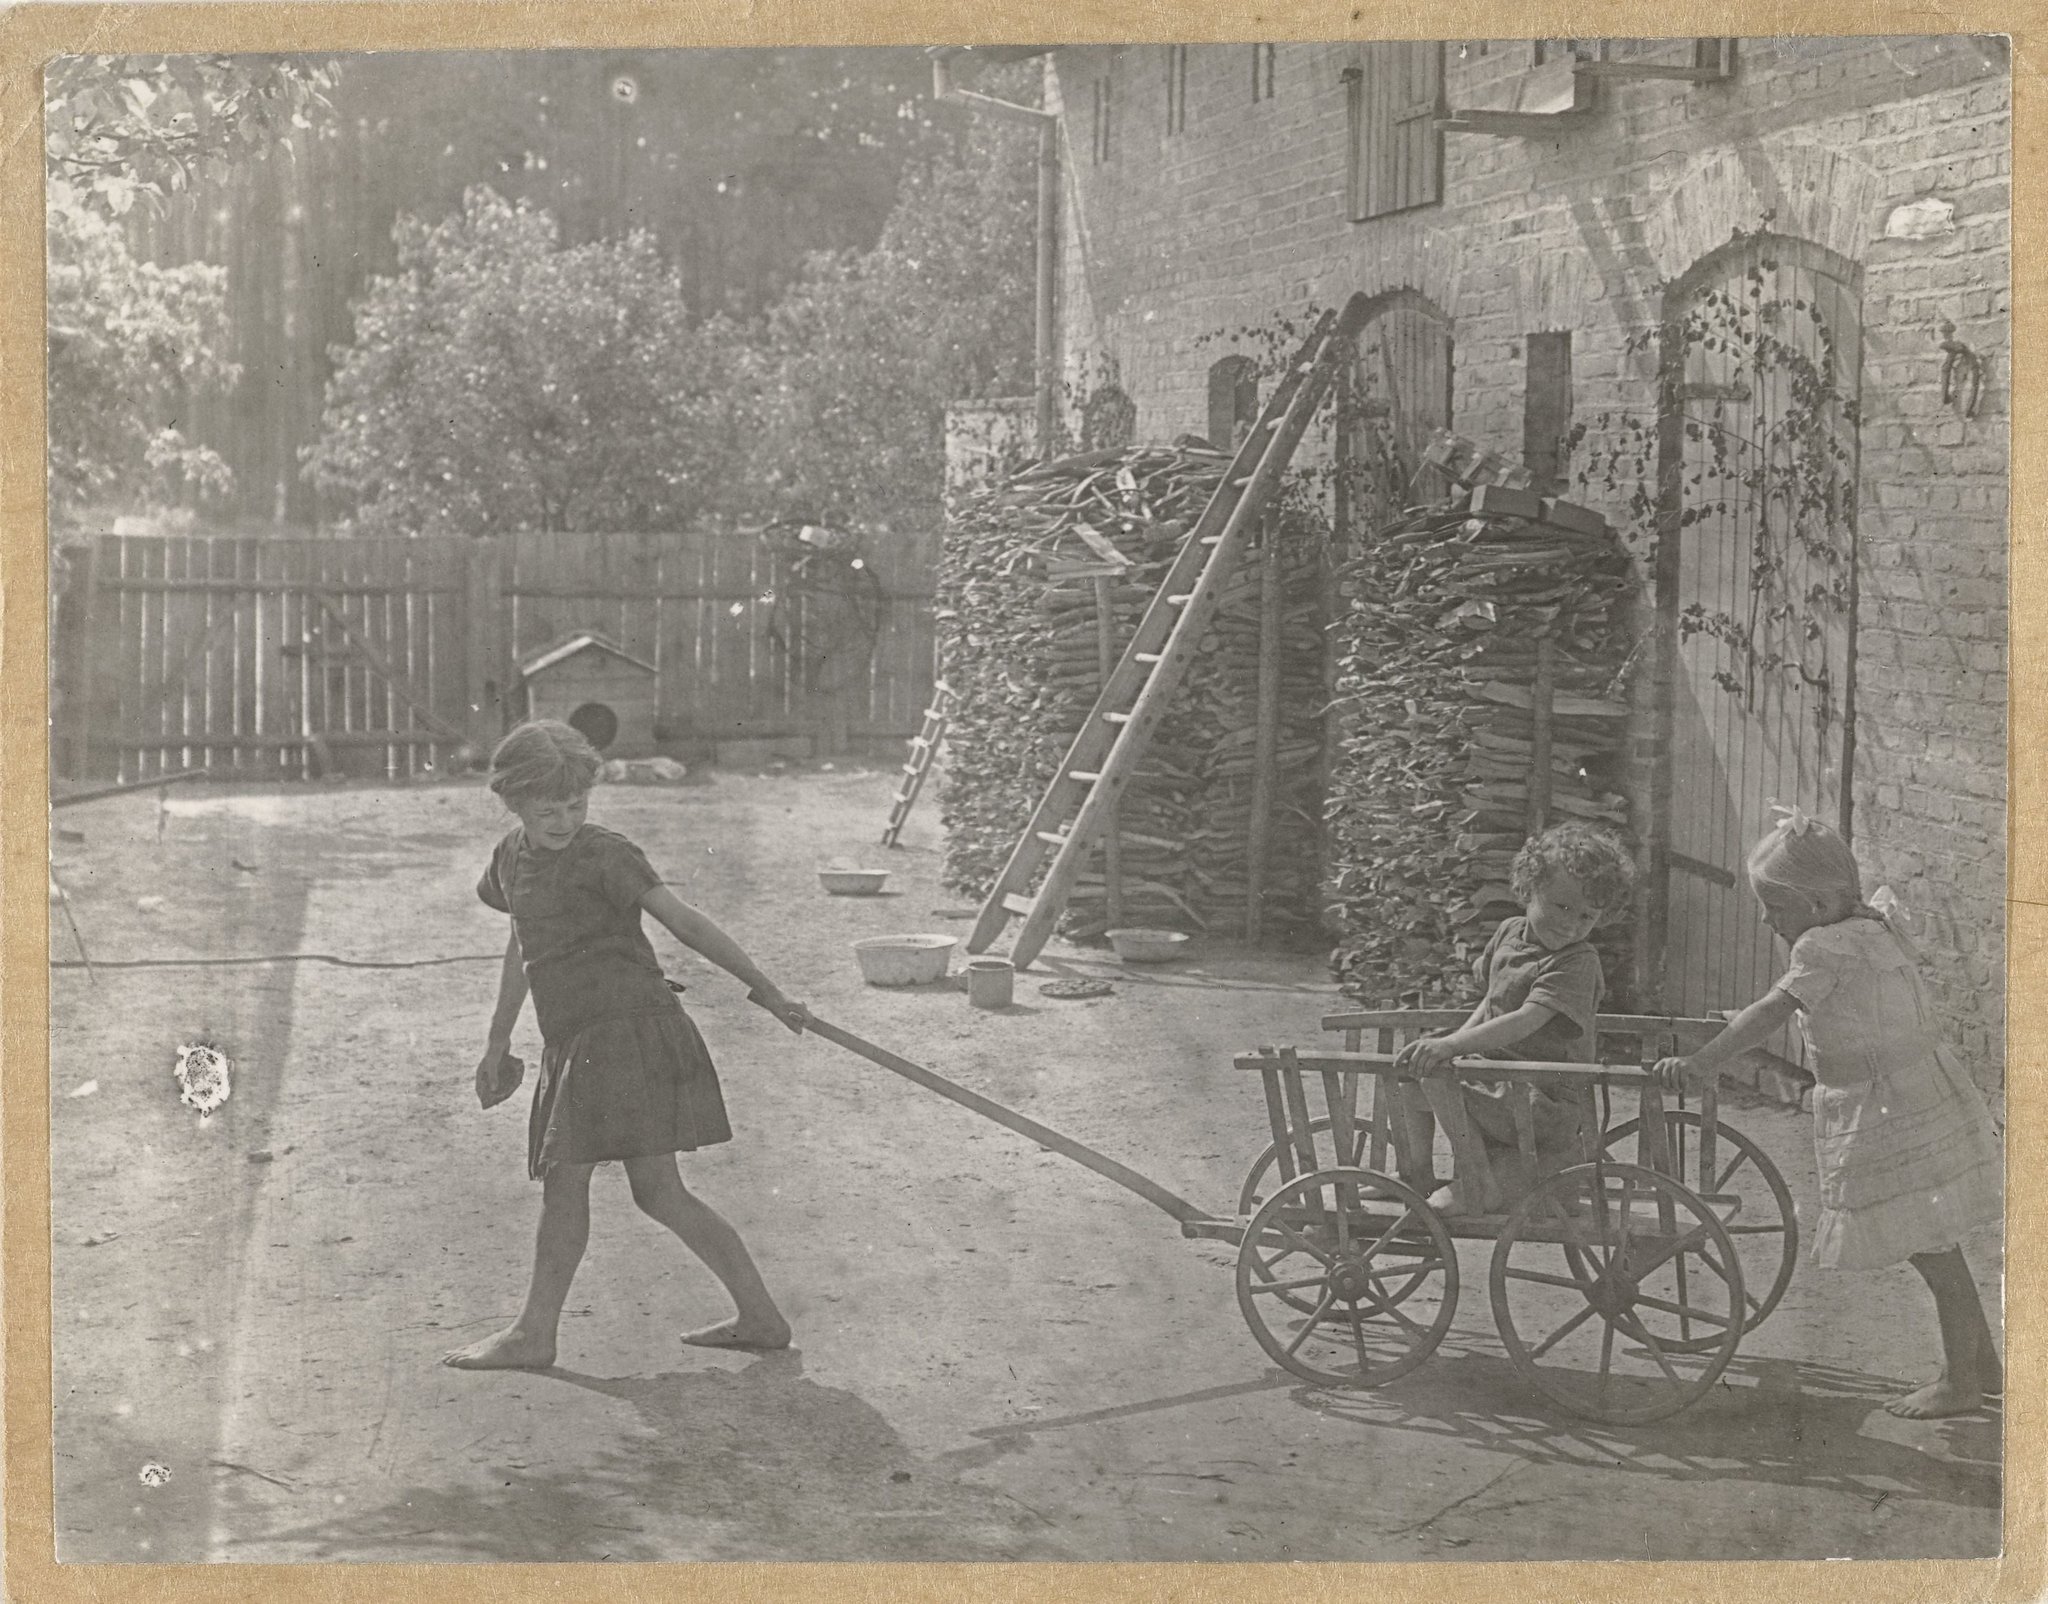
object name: photograph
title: Marba en Eckart Titzenthaler, kinderen van de fotograaf, en een onbekend meisje spelend met een kar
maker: waldemar titzenthaler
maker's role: fotograaf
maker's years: 1869-1937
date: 1917-1919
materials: paper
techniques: gelatin silver print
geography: germany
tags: berlin, engineer, hand-cart, children's games and plays, germany